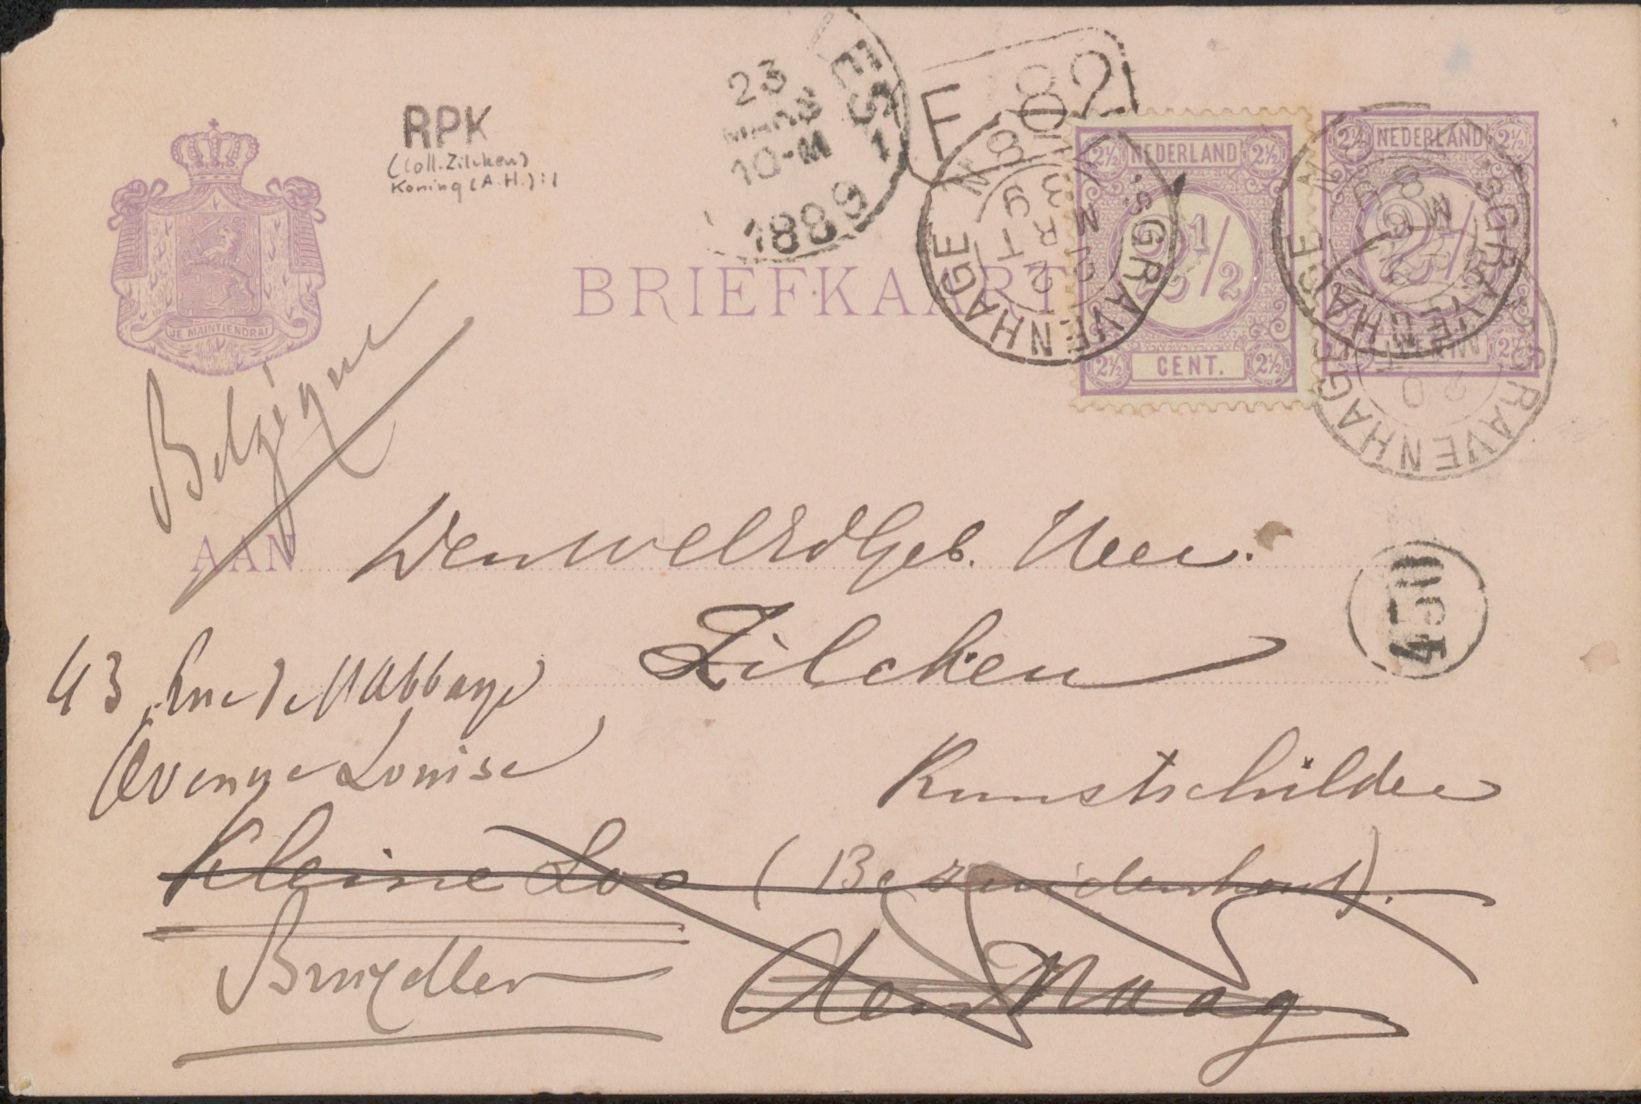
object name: postcard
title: Briefkaart aan Philip Zilcken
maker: arnold koning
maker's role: print maker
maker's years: 1860-1945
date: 1889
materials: cardboard, ink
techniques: pen, writing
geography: the hague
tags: painter, philip zilcken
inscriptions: collector's mark: ‘RPK’